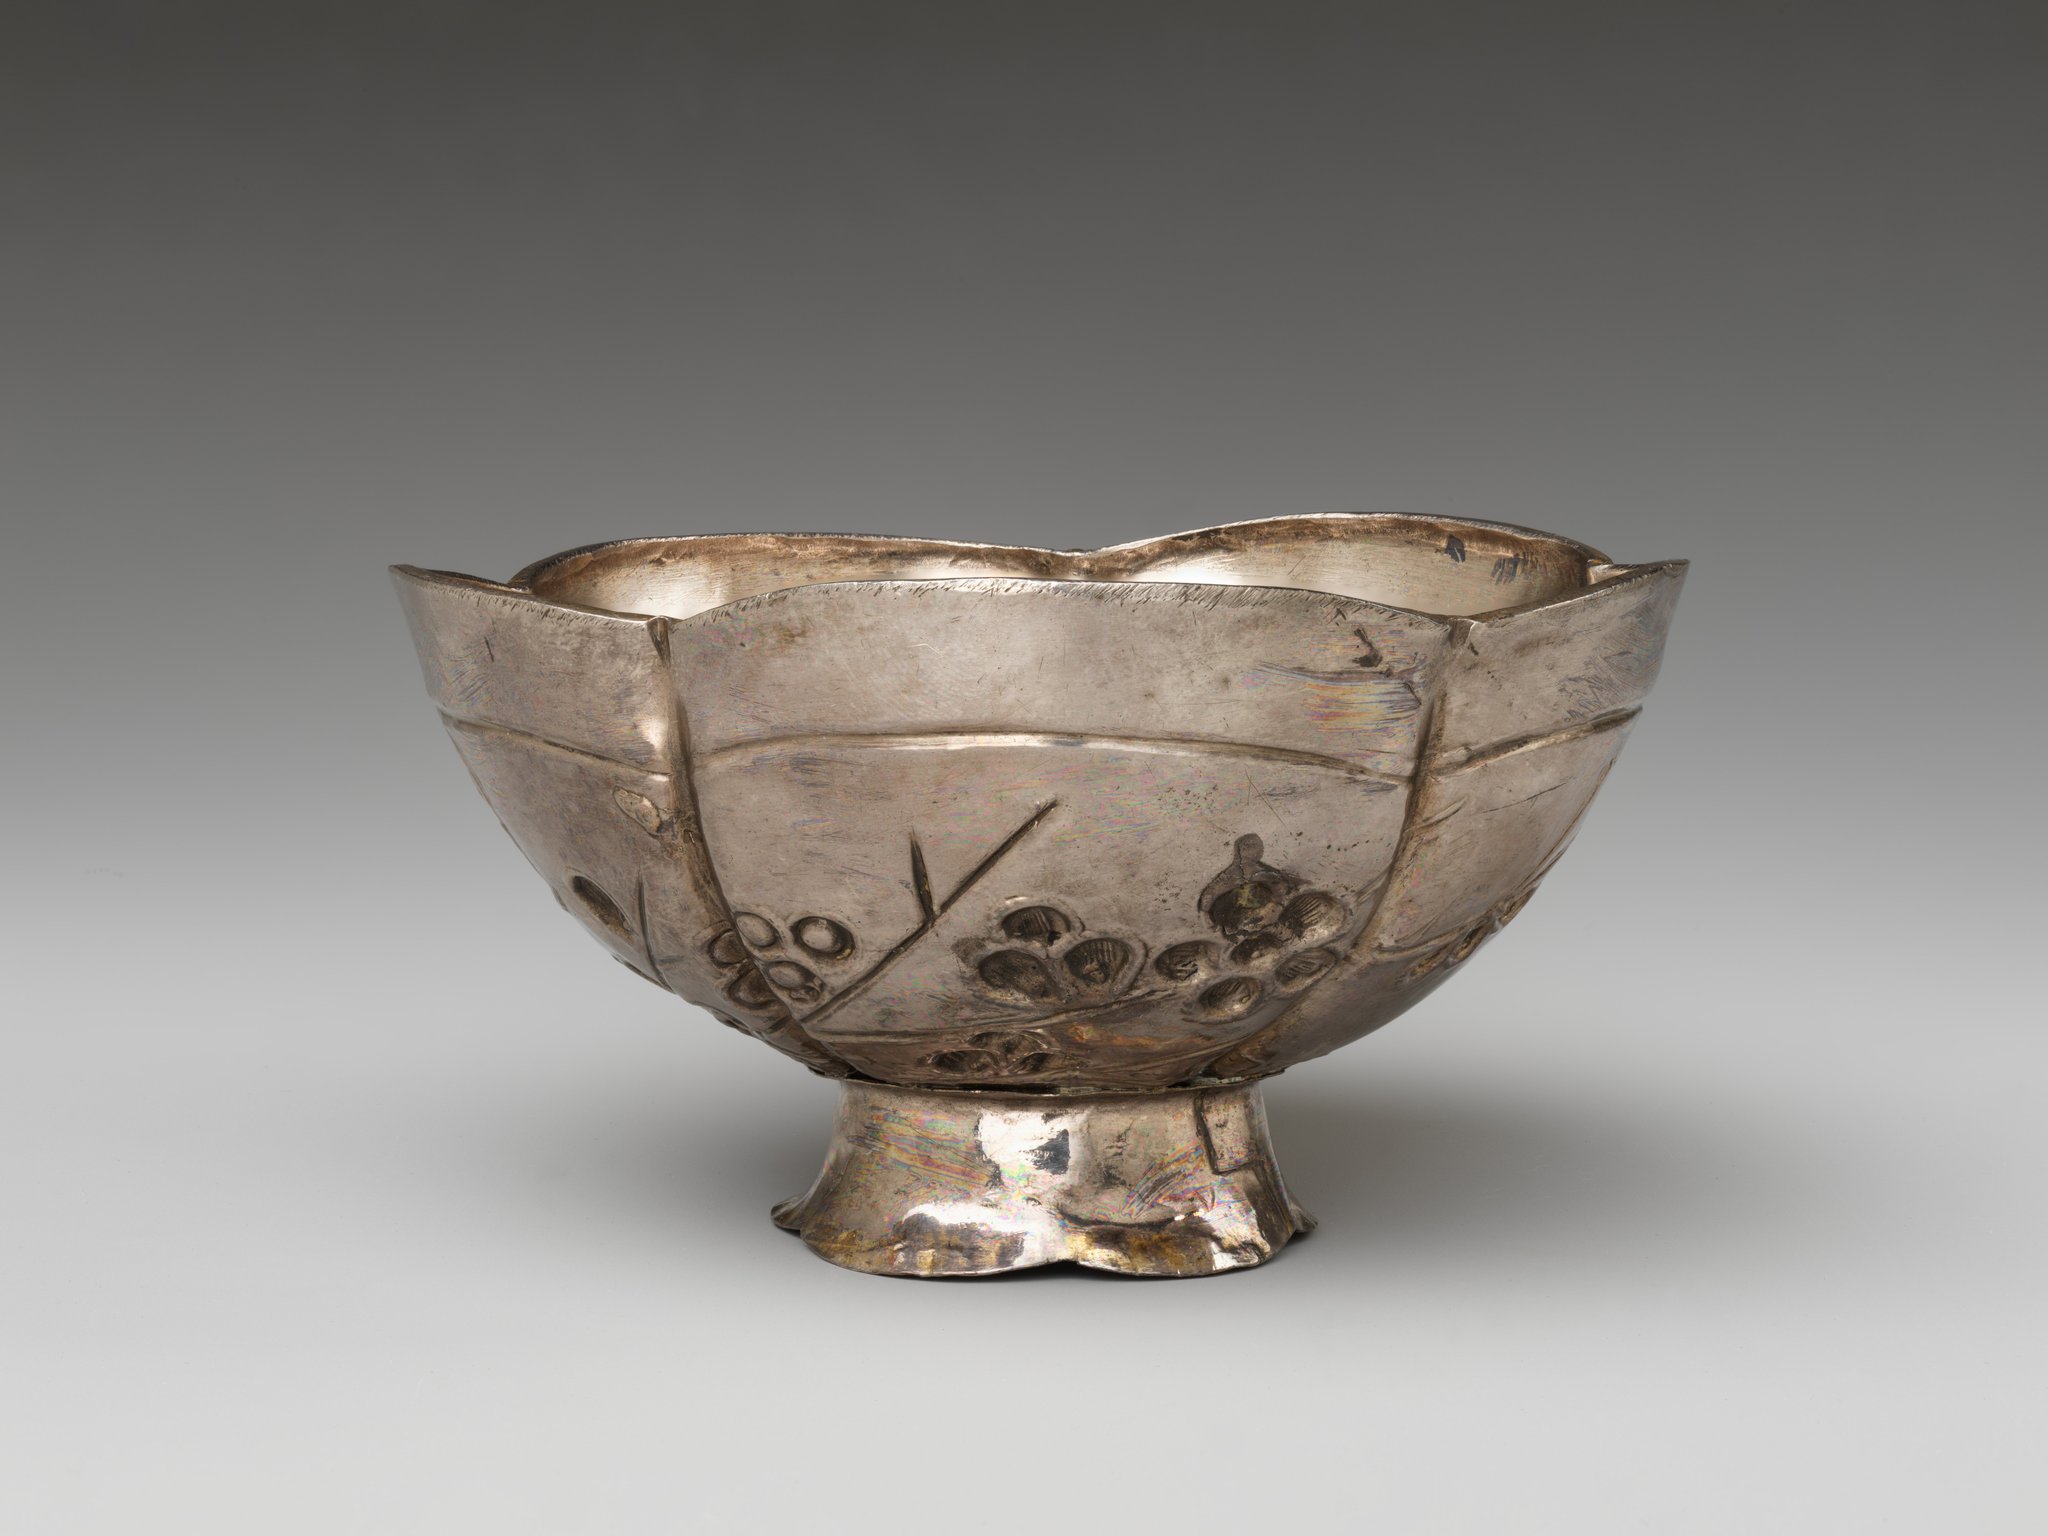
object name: cup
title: Cup with Plum and Crescent Moon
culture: chinese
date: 1201-1400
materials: silver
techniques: gilding, repoussé